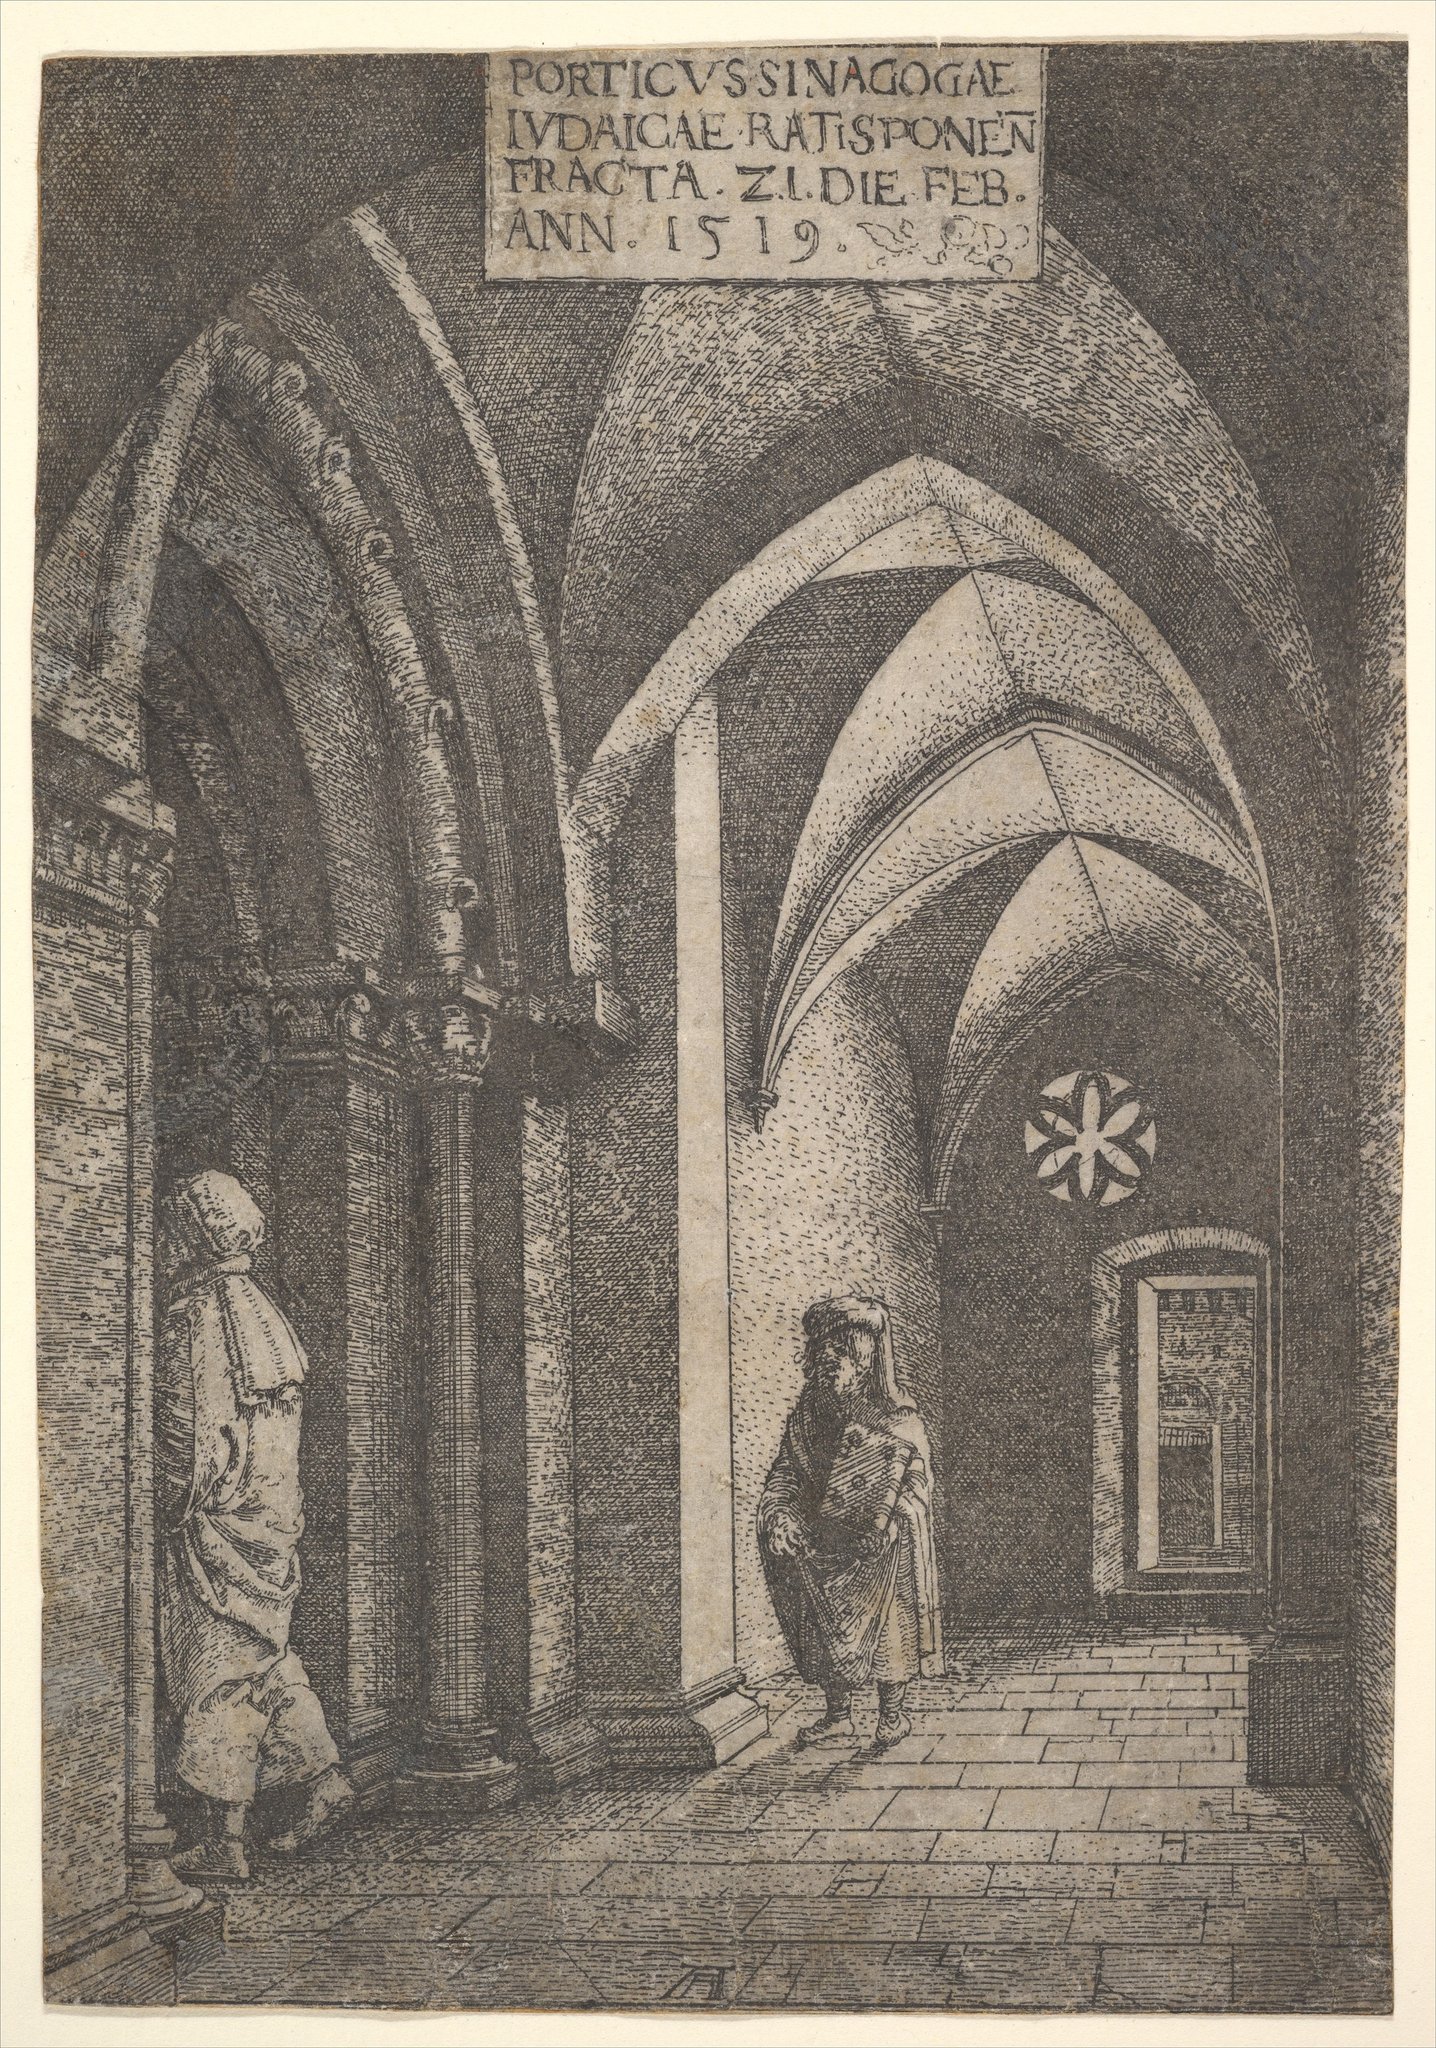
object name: print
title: The Entrance Hall of the Regensburg Synagogue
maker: albrecht altdorfer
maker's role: artist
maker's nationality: german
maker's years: 1480-1538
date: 1519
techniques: etching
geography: germany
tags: human figures,synagogues